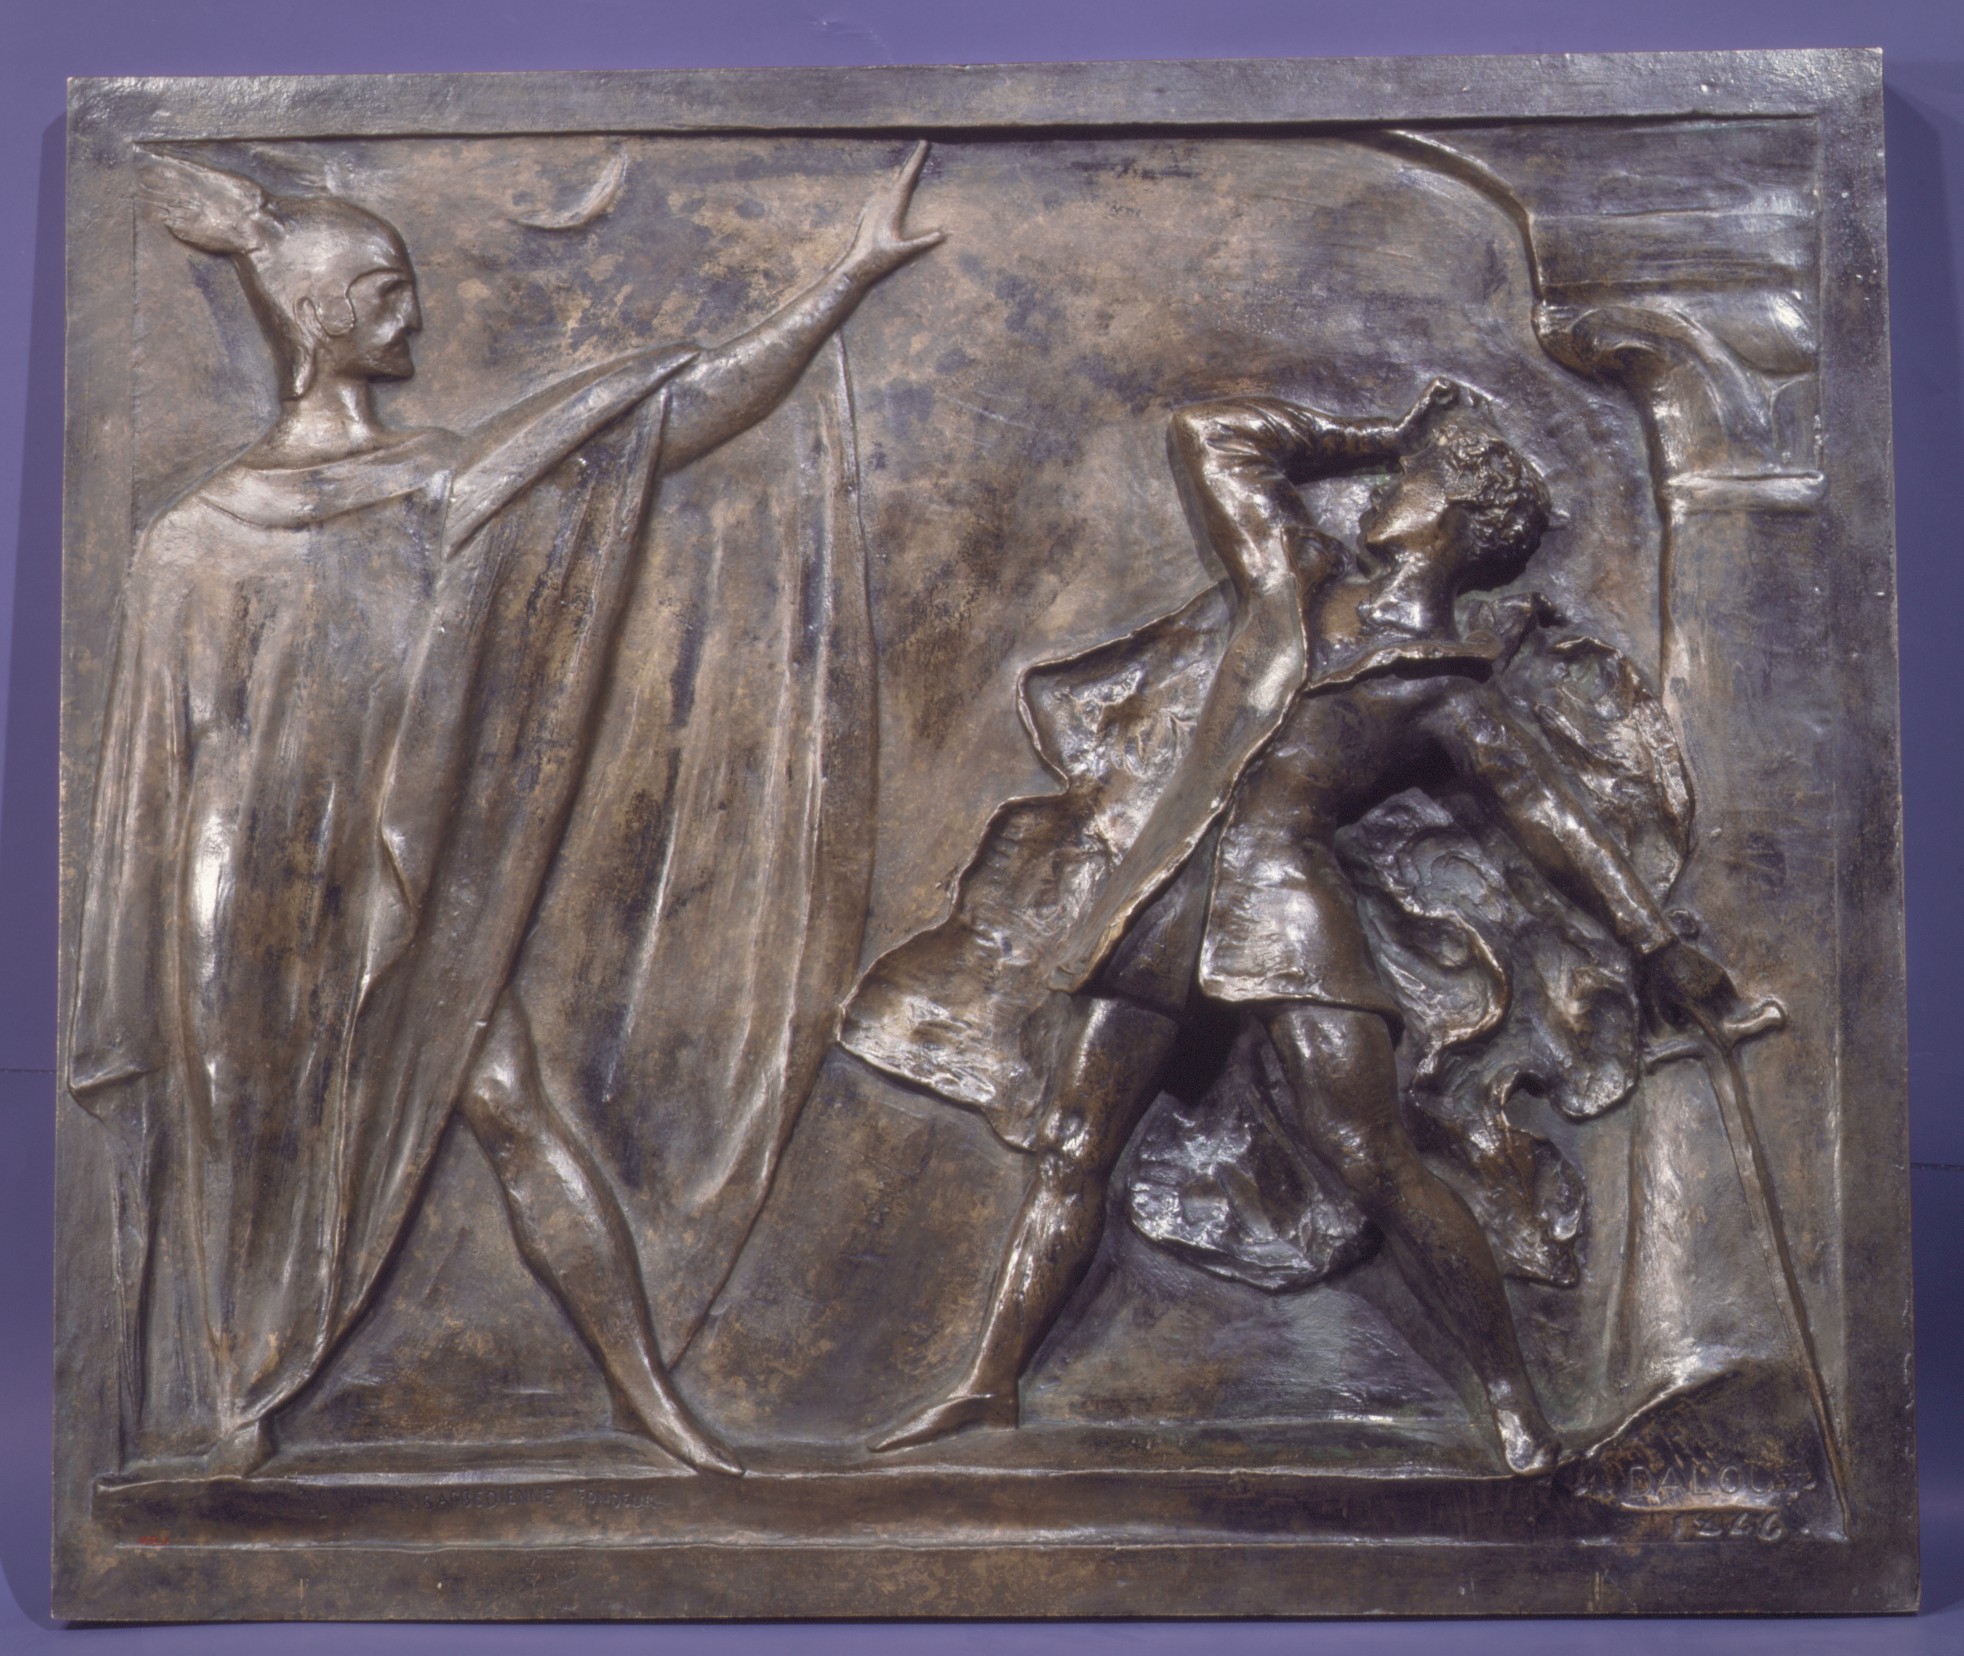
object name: relief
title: The Actor Rouvière in the Role of Hamlet, Recoiling Before the Ghost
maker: auguste préault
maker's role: artist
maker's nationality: french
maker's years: 1809-1879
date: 1866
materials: bronze, patina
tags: theatre,shakespeare,men,actors,hamlet